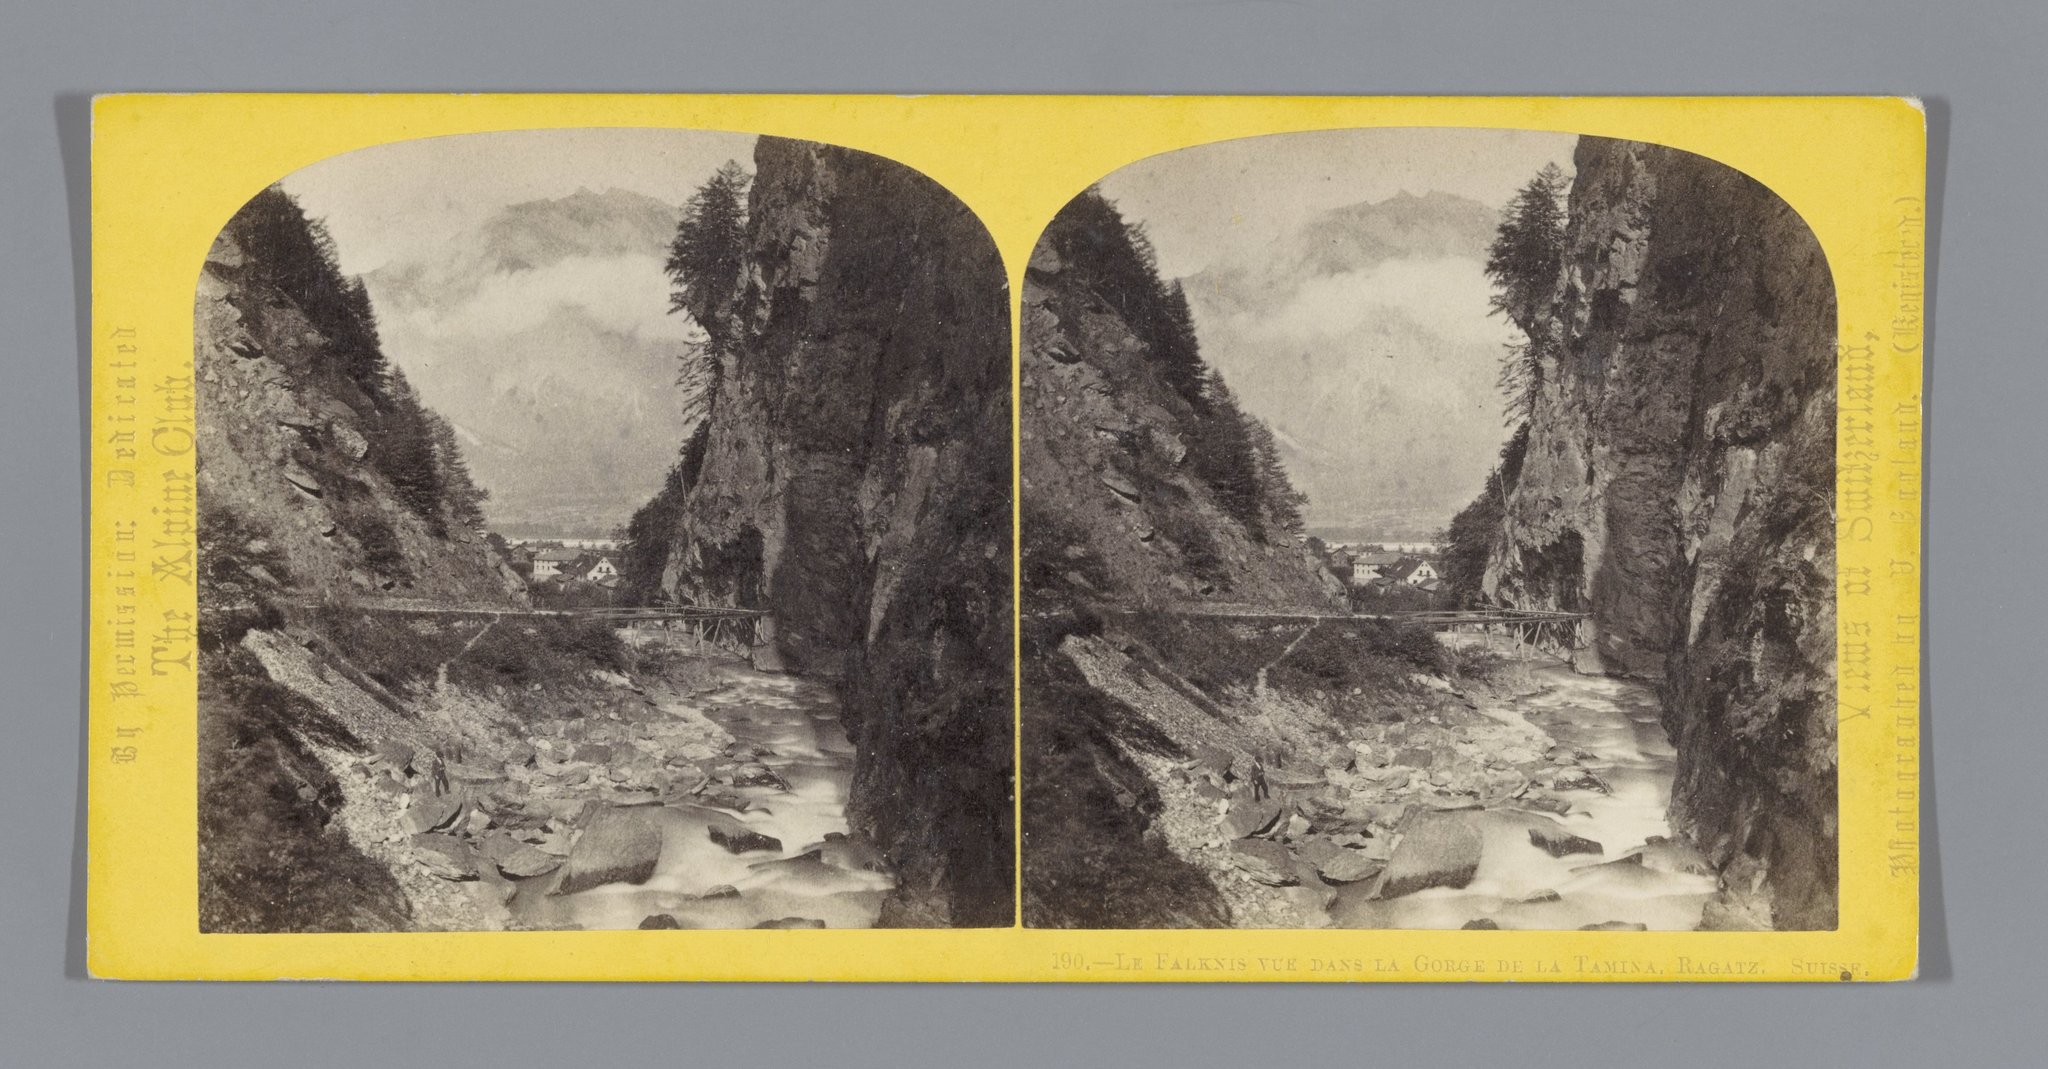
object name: stereograph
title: Taminakloof, met op de achtergrond de Falknis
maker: william england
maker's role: fotograaf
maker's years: 1816-1896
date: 1850-1880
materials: cardboard, photographic support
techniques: albumen print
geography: taminakloof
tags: ravine, chasm, abyss, canyon, mountains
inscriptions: inscription: ‘1867. Juli. No 2 - Aug. 1887. - Aug. 1897.’, inscription: ‘Views of Switzerland, photographed by W. England. (Registered) Under the Special Patronage of the Alpine Club.’, number: ‘190.’